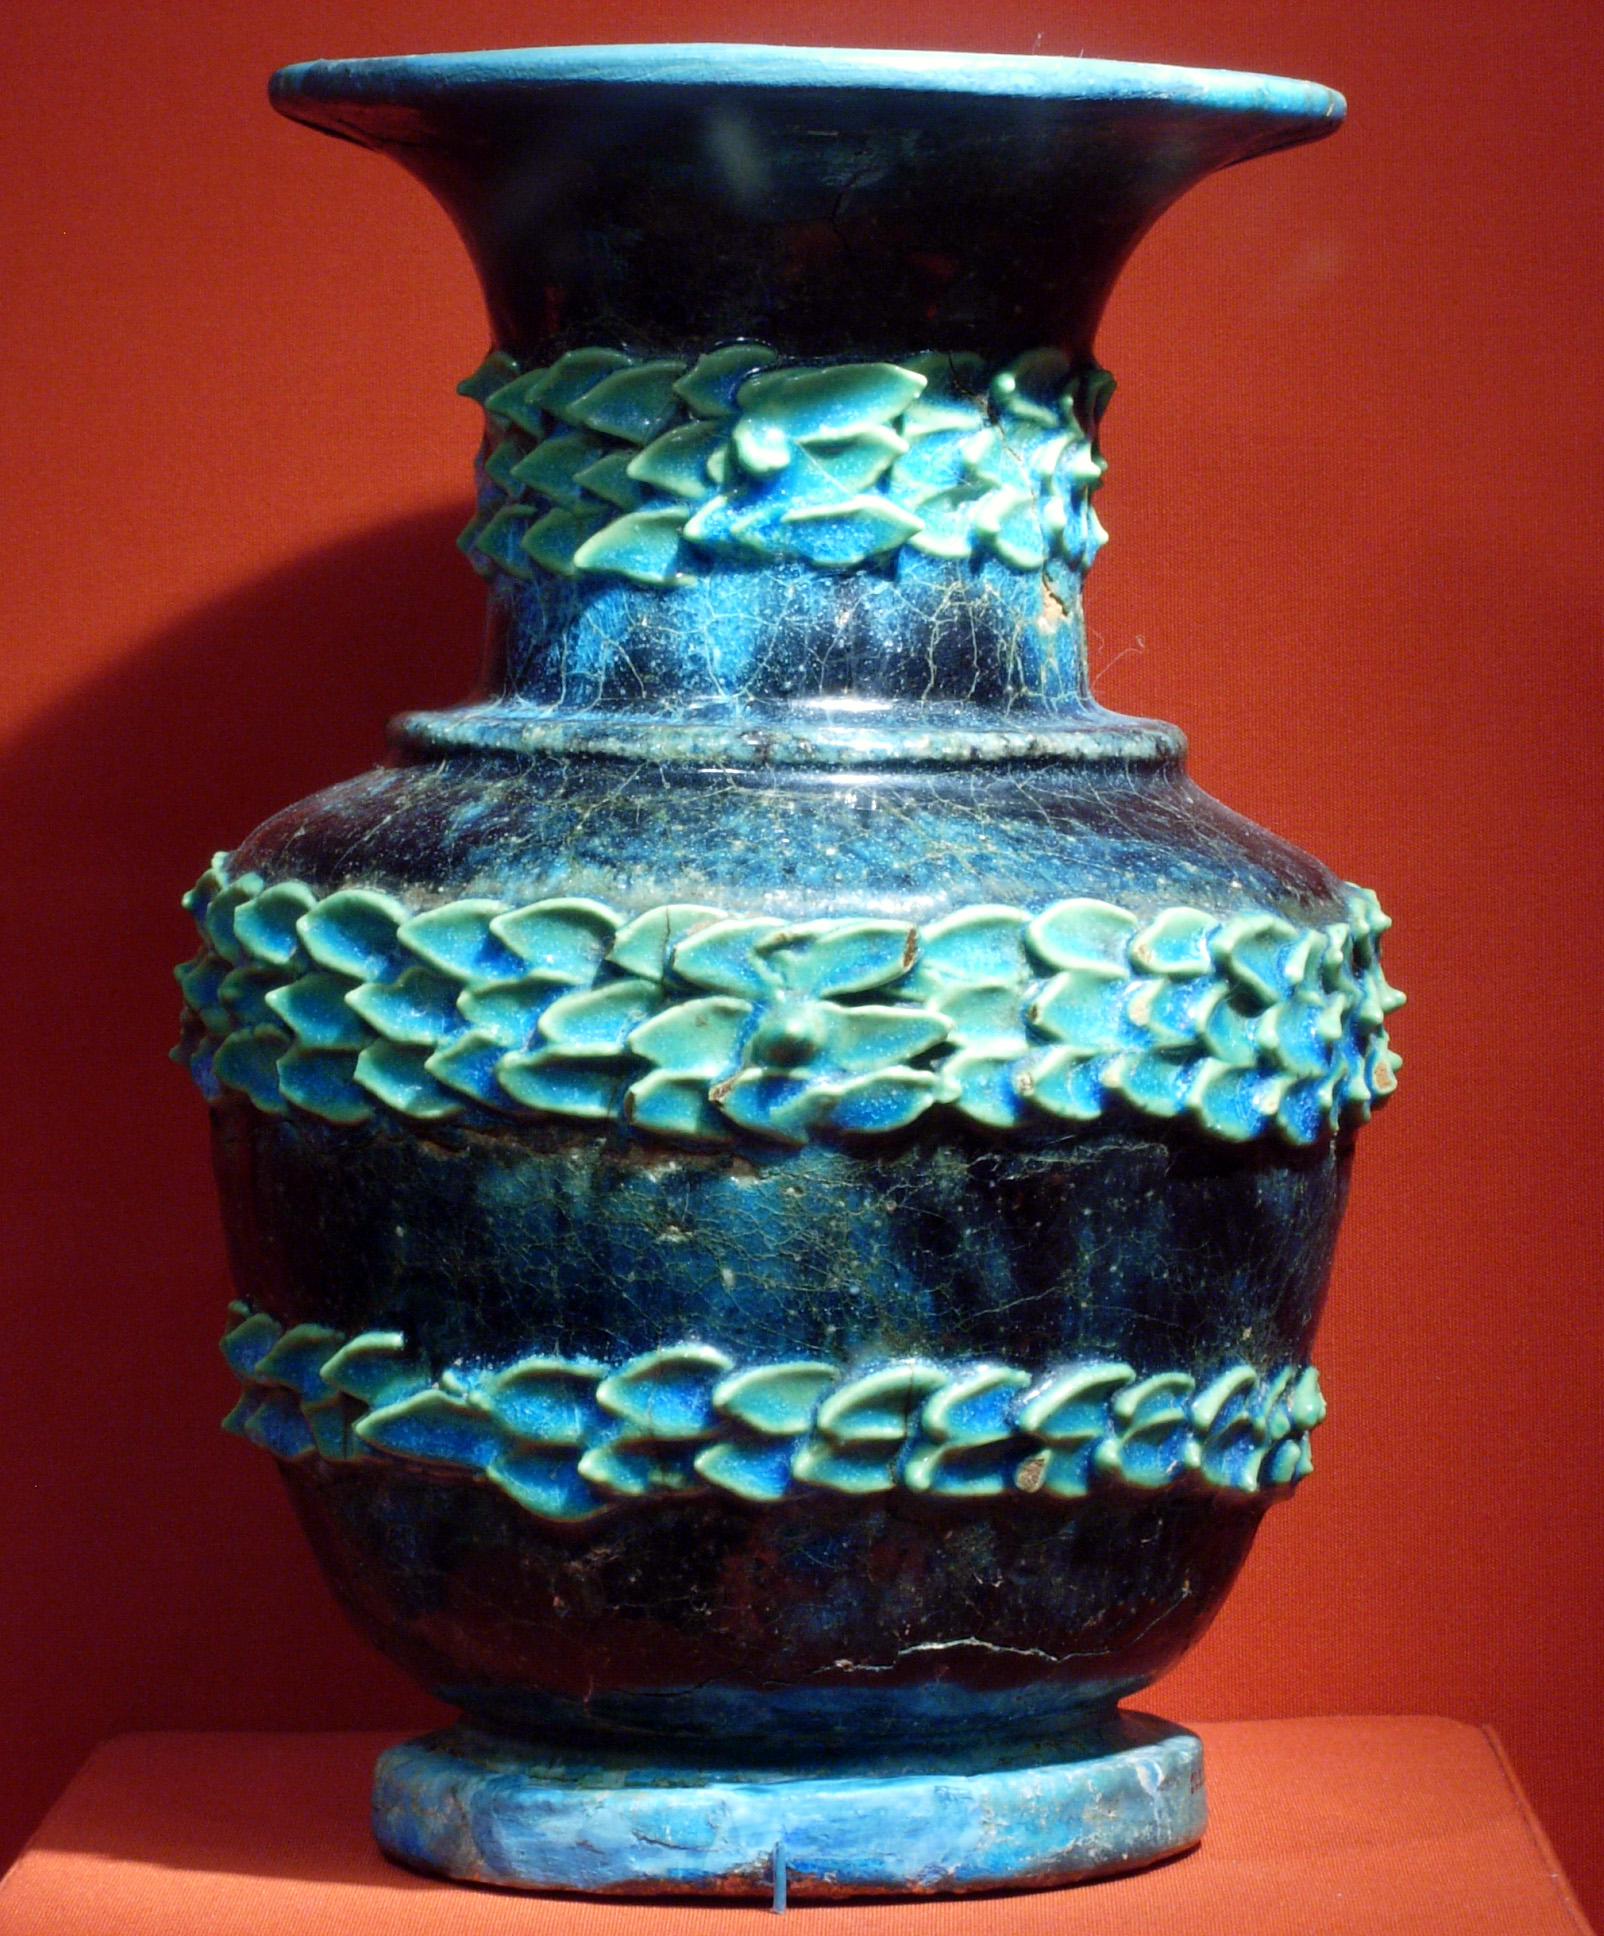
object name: vase, decorated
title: Decorated Vase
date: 1-100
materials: faience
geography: fayum